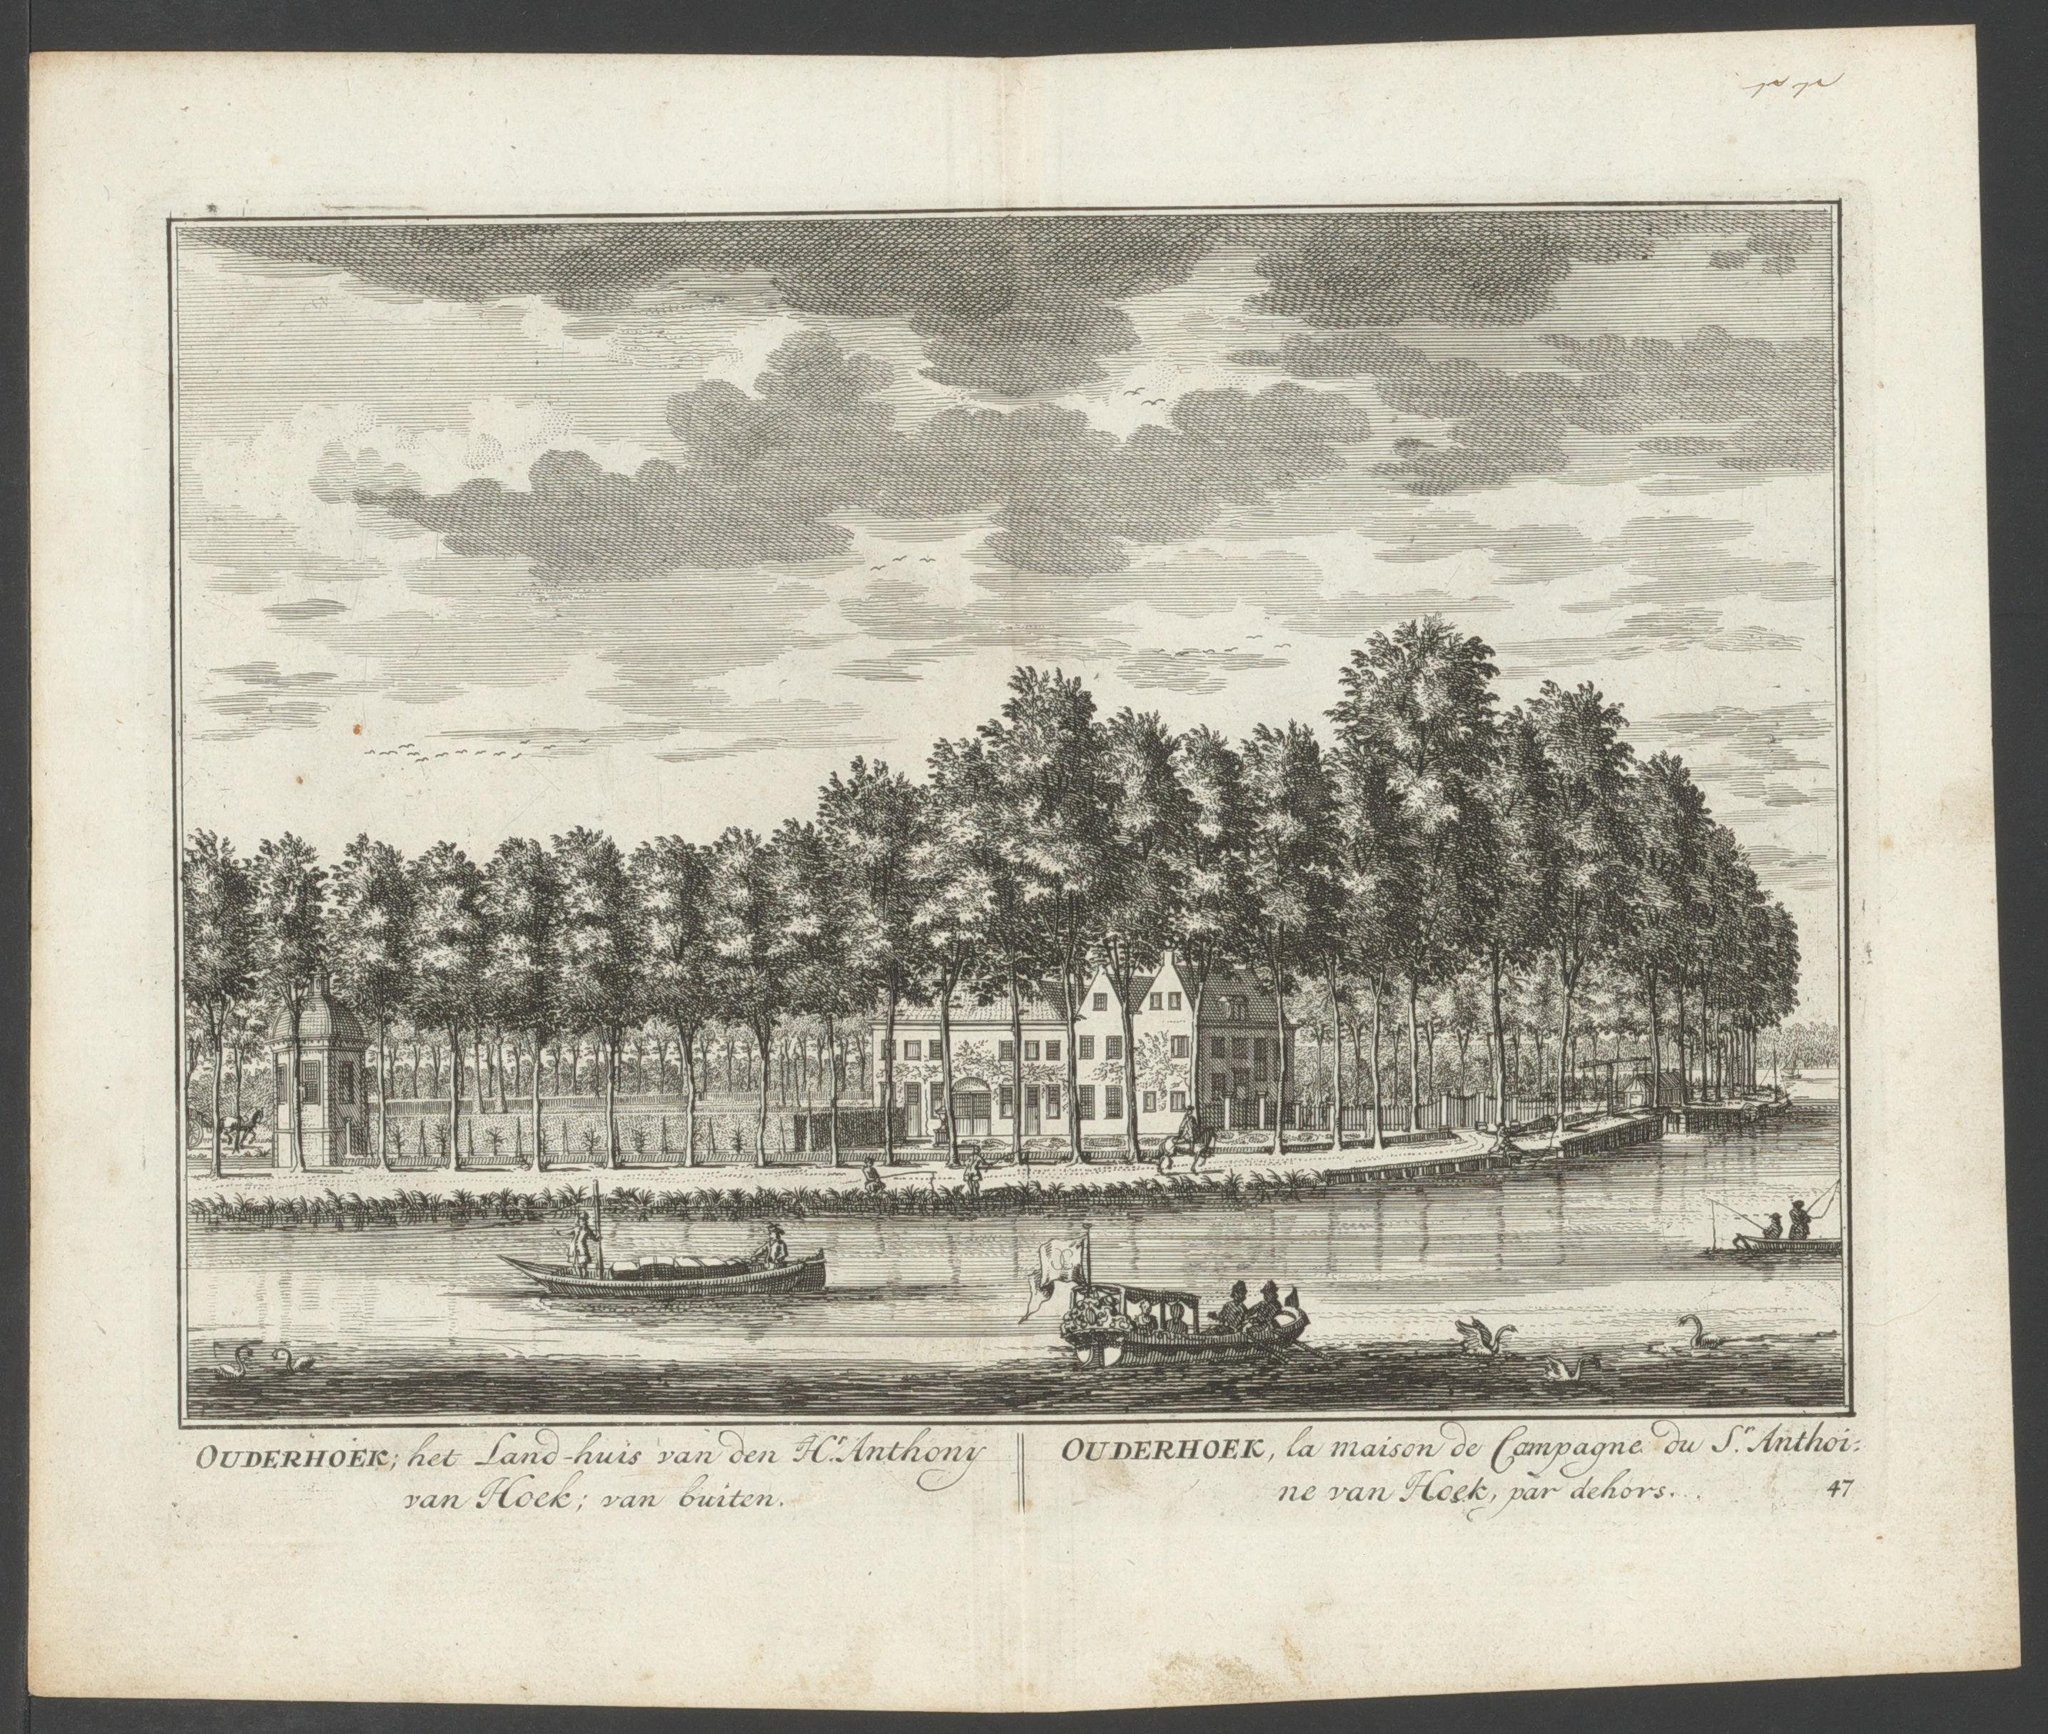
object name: print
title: Gezicht op de buitenplaats Ouderhoek aan de Vecht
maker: daniël stopendaal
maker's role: print maker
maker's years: 1672-1726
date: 1790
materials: paper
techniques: engraving, etching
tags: river (+ landscape with figures, staffage), country-house, vecht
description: Prent voor het eerst gebruikt in: Leth, Andries de. De zegepraalende Vecht, vertoonende verscheidene gesichten van lustplaatsen, heeren huysen en dorpen, beginnende van Uitrecht en met Muyden besluytende (...). Amsterdam: Weduwe Nicolaus Visscher, 1719. Prent mogelijk uit: Brouërius van Nidek, Matthaeus. De Vechtstroom, van Utrecht tot Muiden (...). Amsterdam: H. Gartman, W. Vermandel en J.W. Smit, 1790.